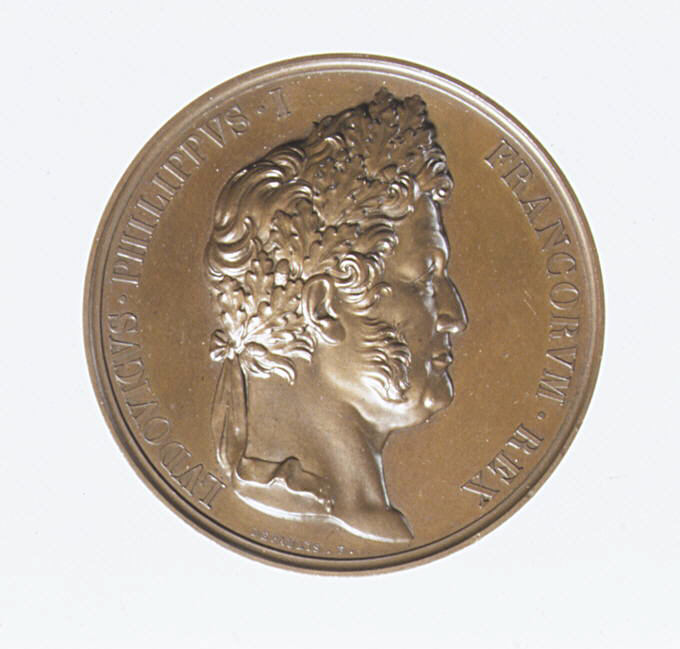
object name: medal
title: Accession of Louis-Philippe, August 9, 1830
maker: alexis joseph depaulis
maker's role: artist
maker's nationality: french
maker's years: 1790-1867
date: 1830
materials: bronze, copper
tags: men,profiles